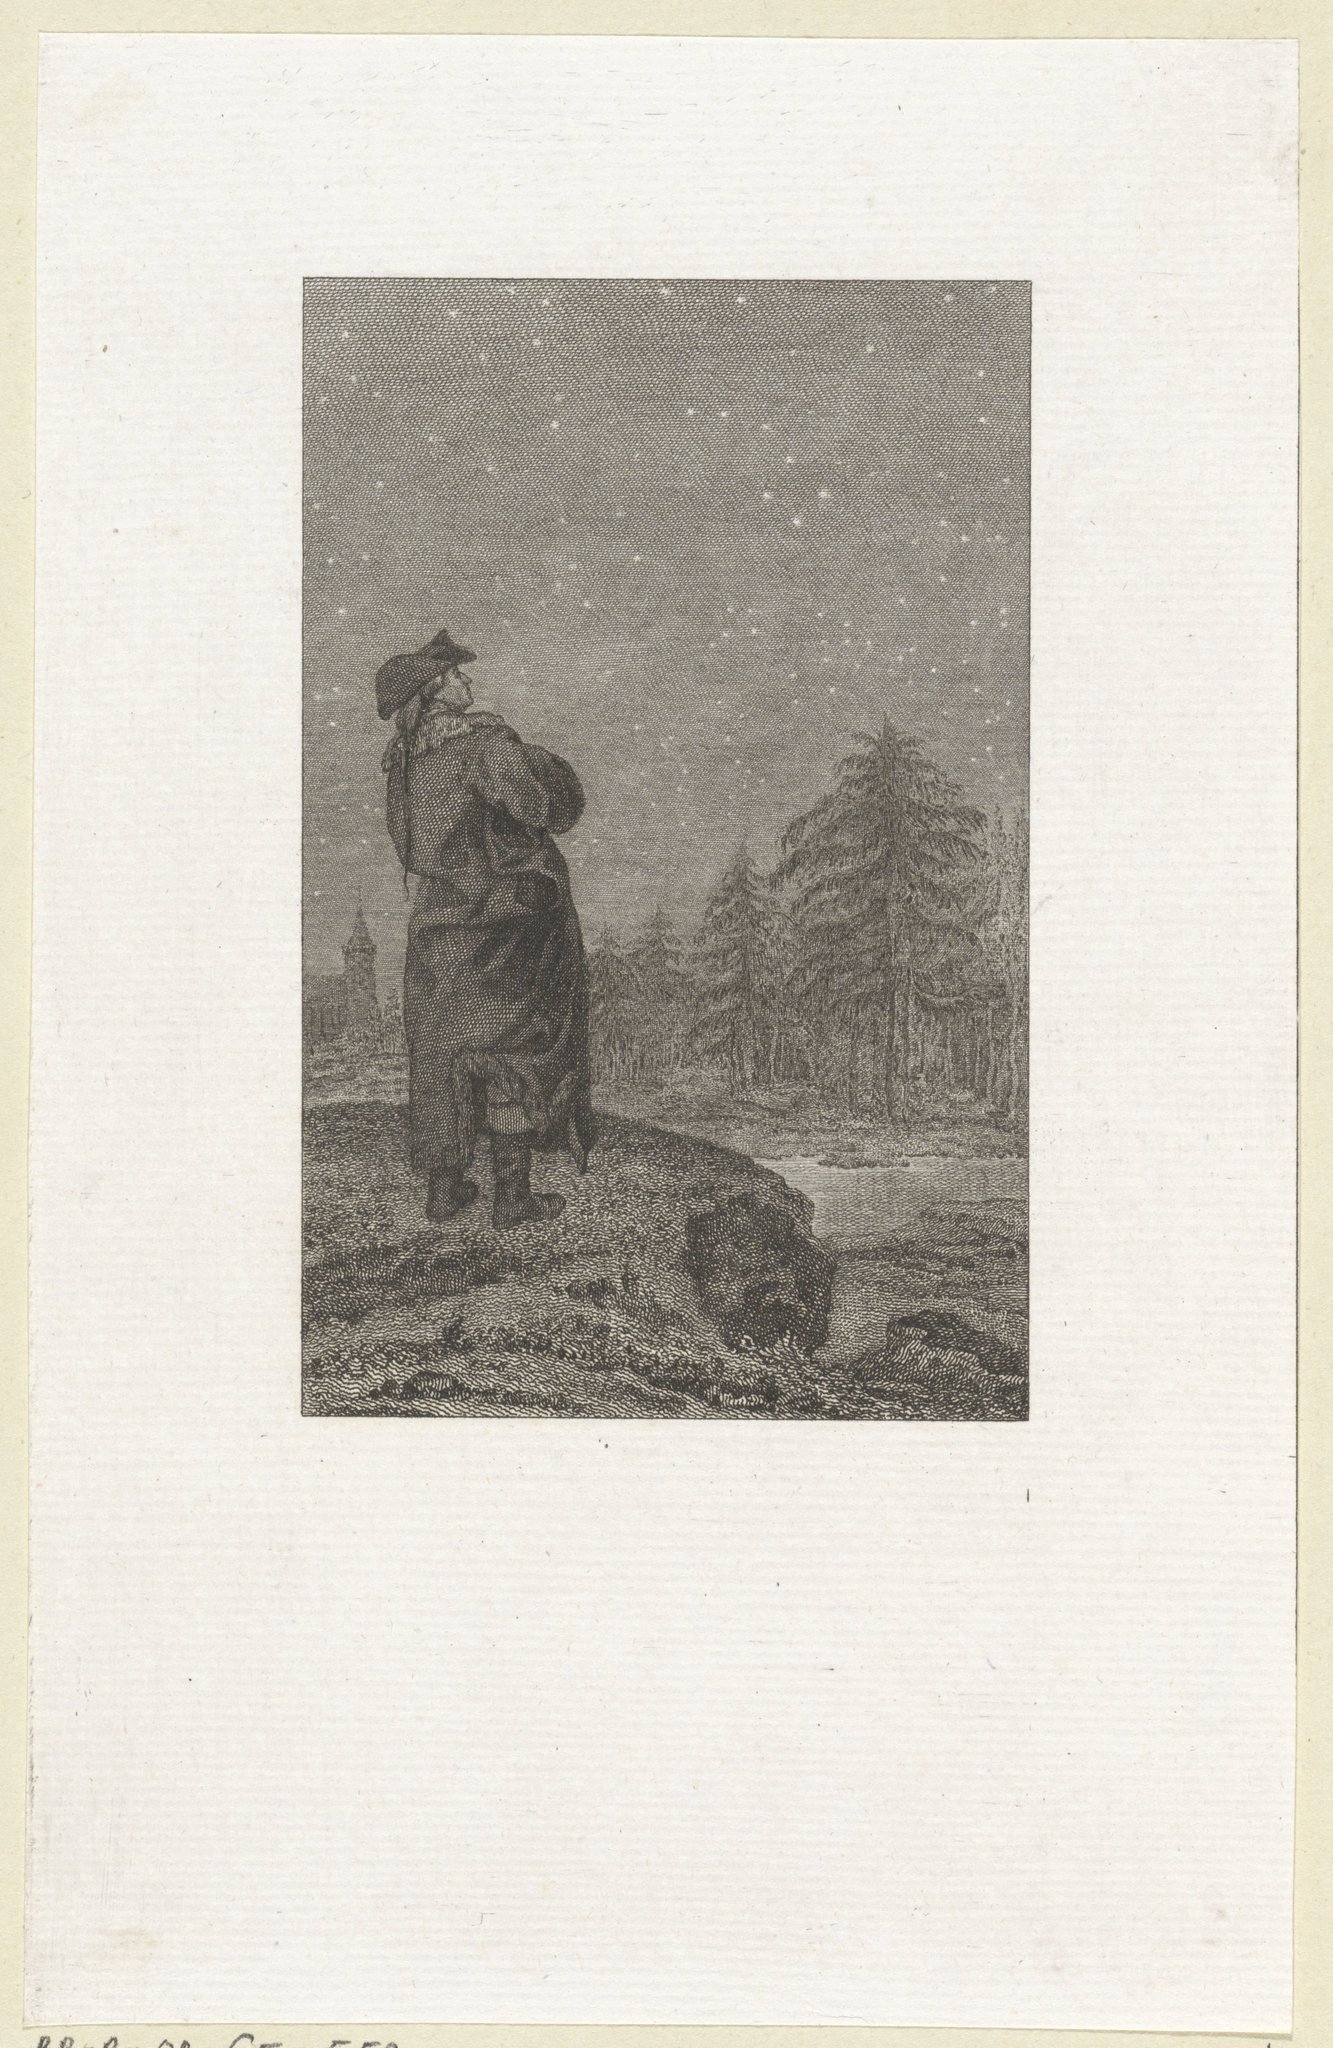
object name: print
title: Ferdinand staat in een landschap en tuurt naar de sterrenhemel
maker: reinier vinkeles (i)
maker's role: draughtsman, print maker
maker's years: 1741-1816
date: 1785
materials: paper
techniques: engraving, etching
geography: amsterdam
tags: landscapes, church (exterior), forest, wood, stars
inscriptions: collector's mark: Lugt 240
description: Deze prent is ook gebruikt als illustratie in: Rhĳnvis, Feith. Ferdinand et Constance. Amsterdam: Johannes Allart, 1785.